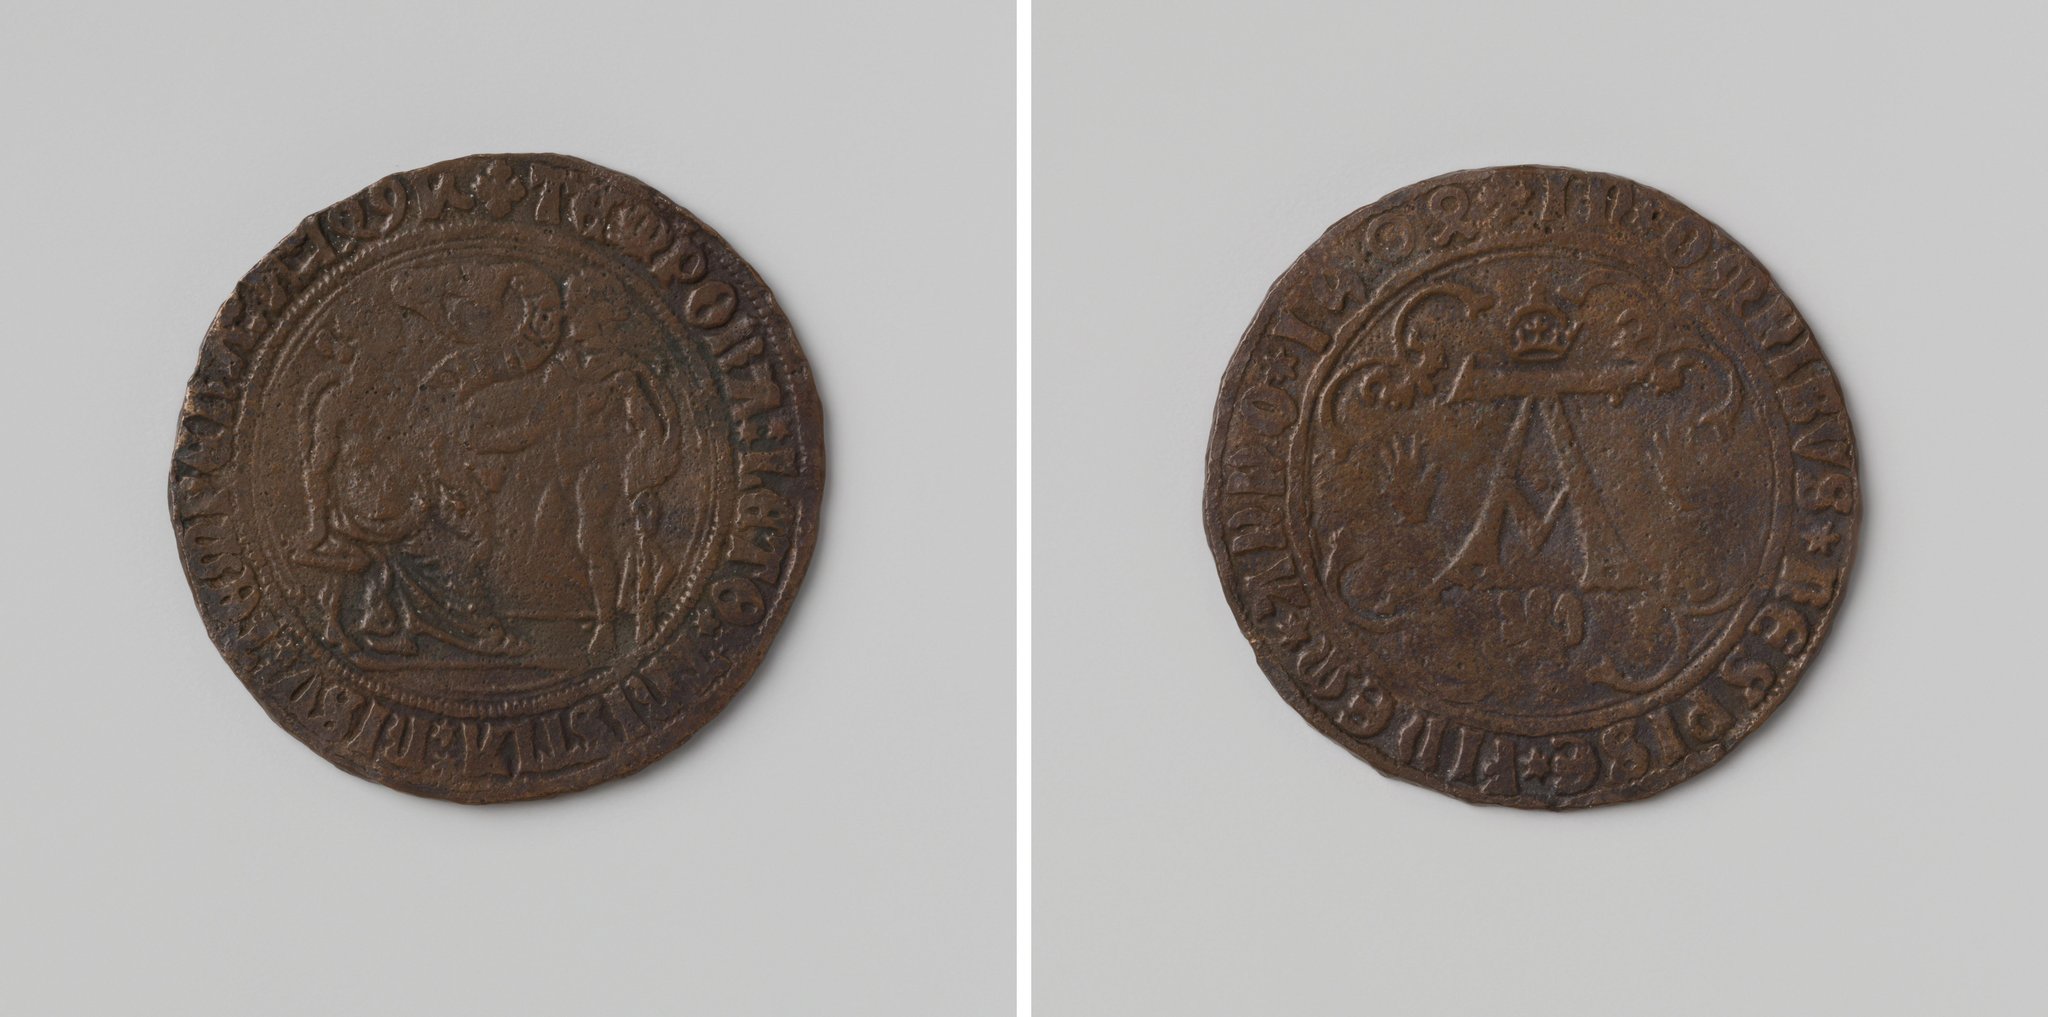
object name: jeton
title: Oorlog van Filips de Schone tegen Karel van Gelre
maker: Anonymous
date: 1504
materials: copper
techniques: striking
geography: antwerp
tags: bruges, filips de schone (hertog van bourgondië), guelders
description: Koperen penning. Voorzijde: zittende vrouw en staande man; tussen hen in wimpel met opschrift binnen omschrift. Keerzijde: letter A binnen vier paren van halve cirkels, onder kroon, boven leeuw, geflankeerd door twee handen binnen omschrift